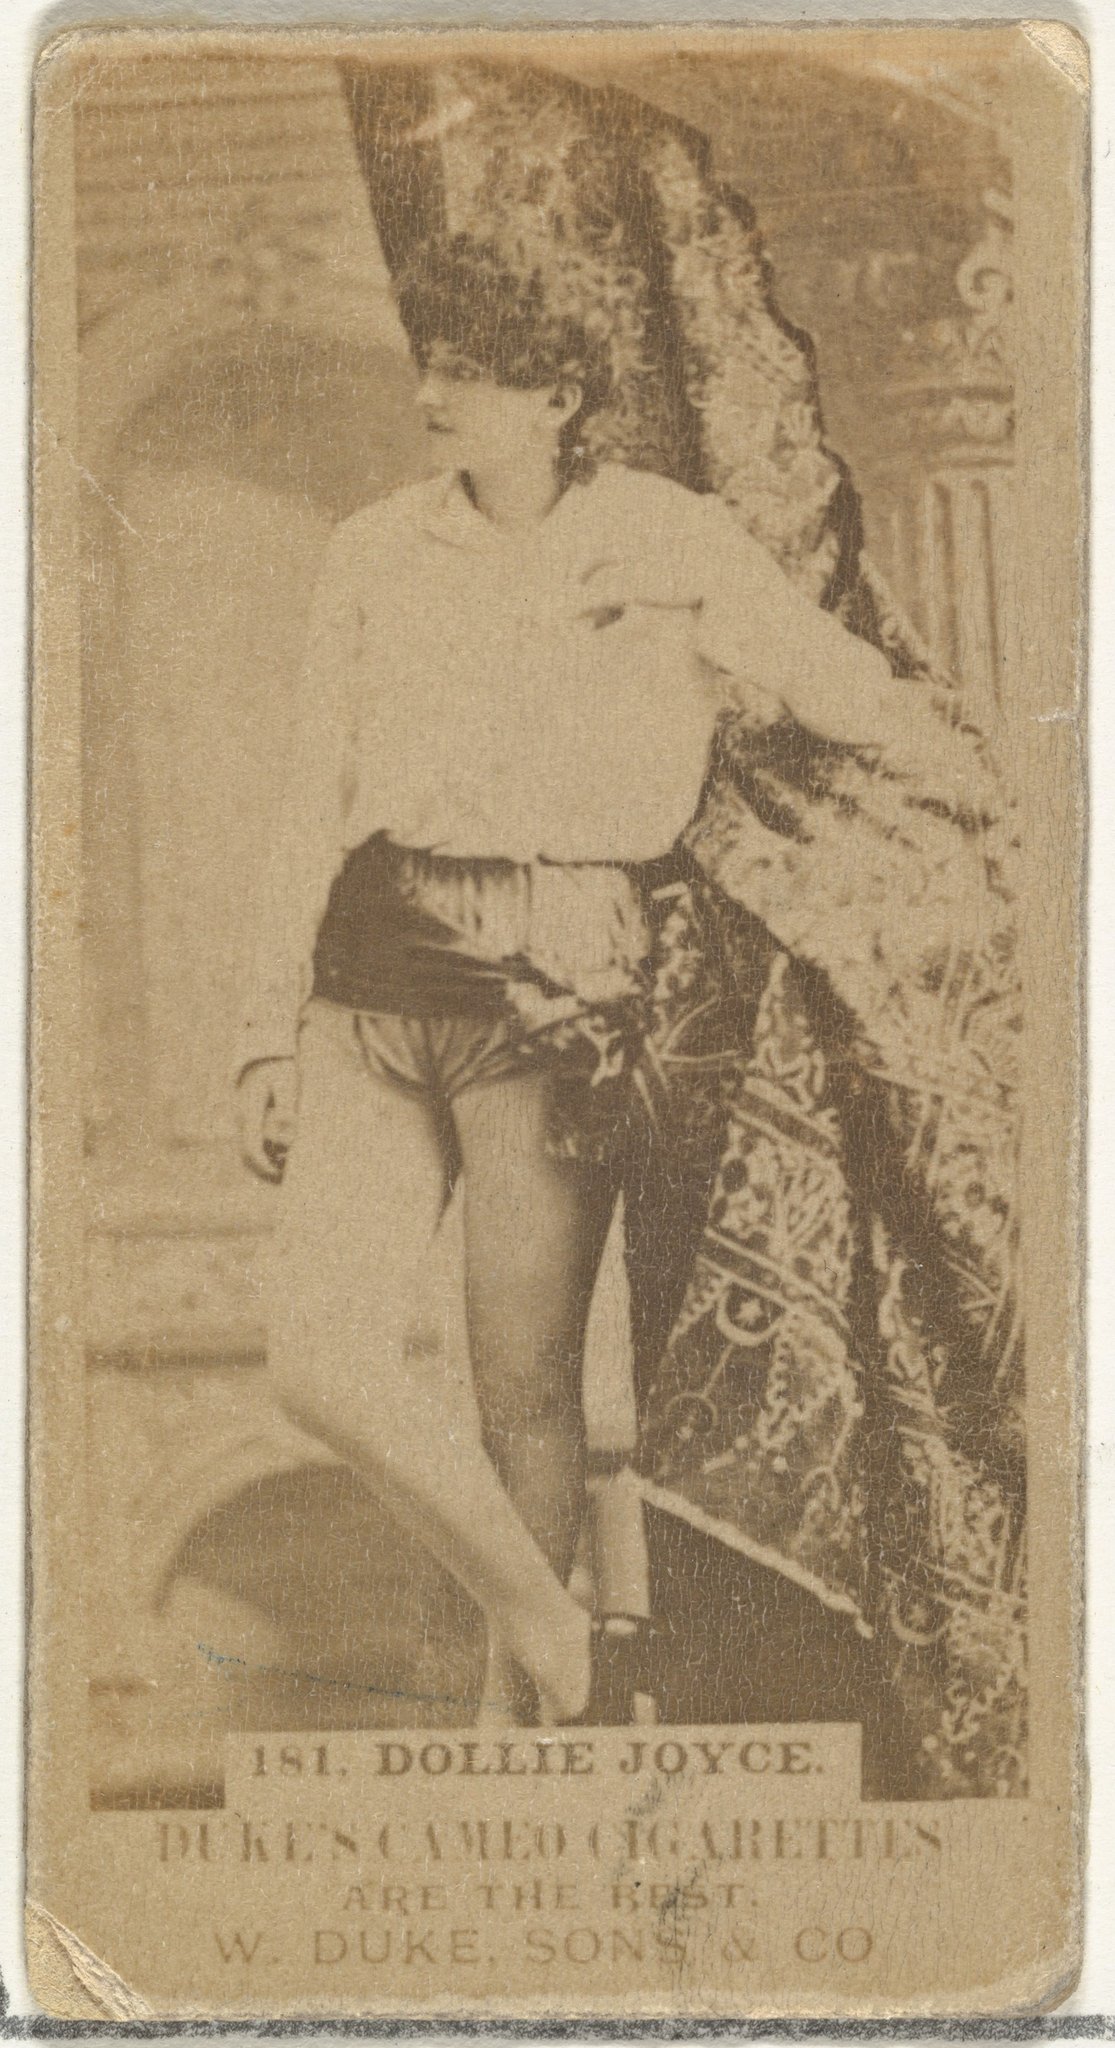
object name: photograph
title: Card Number 181, Dollie Joyce, from the Actors and Actresses series (N145-5) issued by Duke Sons & Co. to promote Cameo Cigarettes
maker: w. duke, sons & co.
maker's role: publisher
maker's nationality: american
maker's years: 1870-1920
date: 1880-1889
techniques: albumen silver print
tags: women,actresses